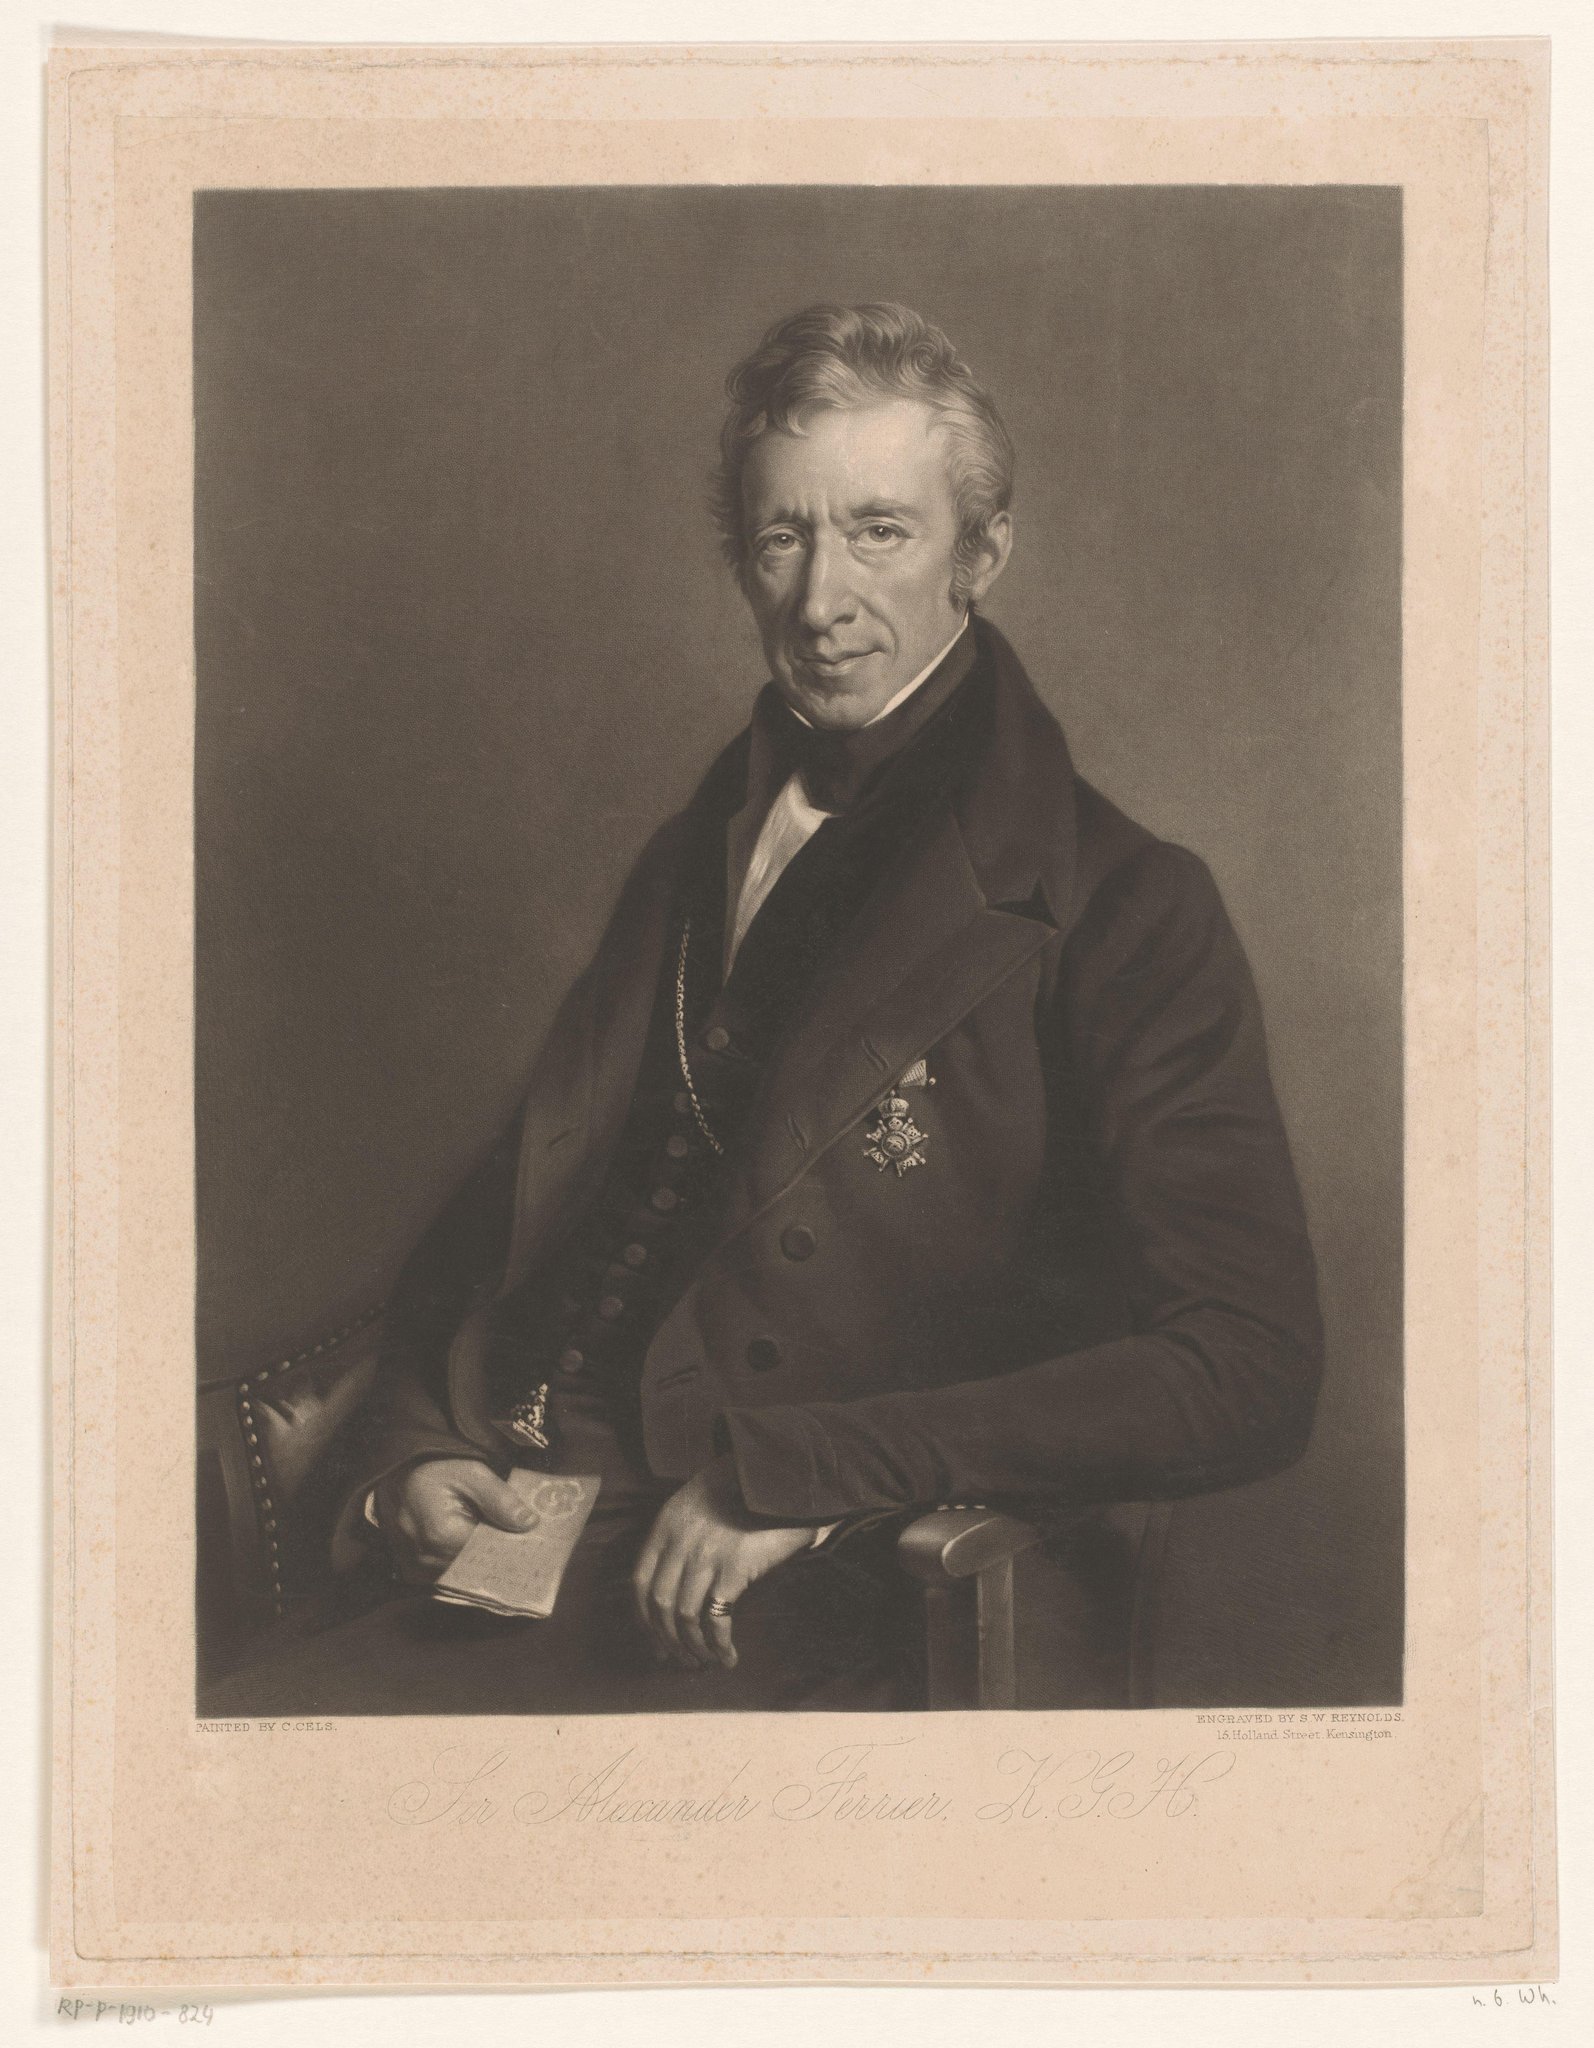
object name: print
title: Portret van Alexander Ferrier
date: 1783-1835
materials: paper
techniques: etching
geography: london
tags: historical persons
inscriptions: collector's mark: Lugt 2228